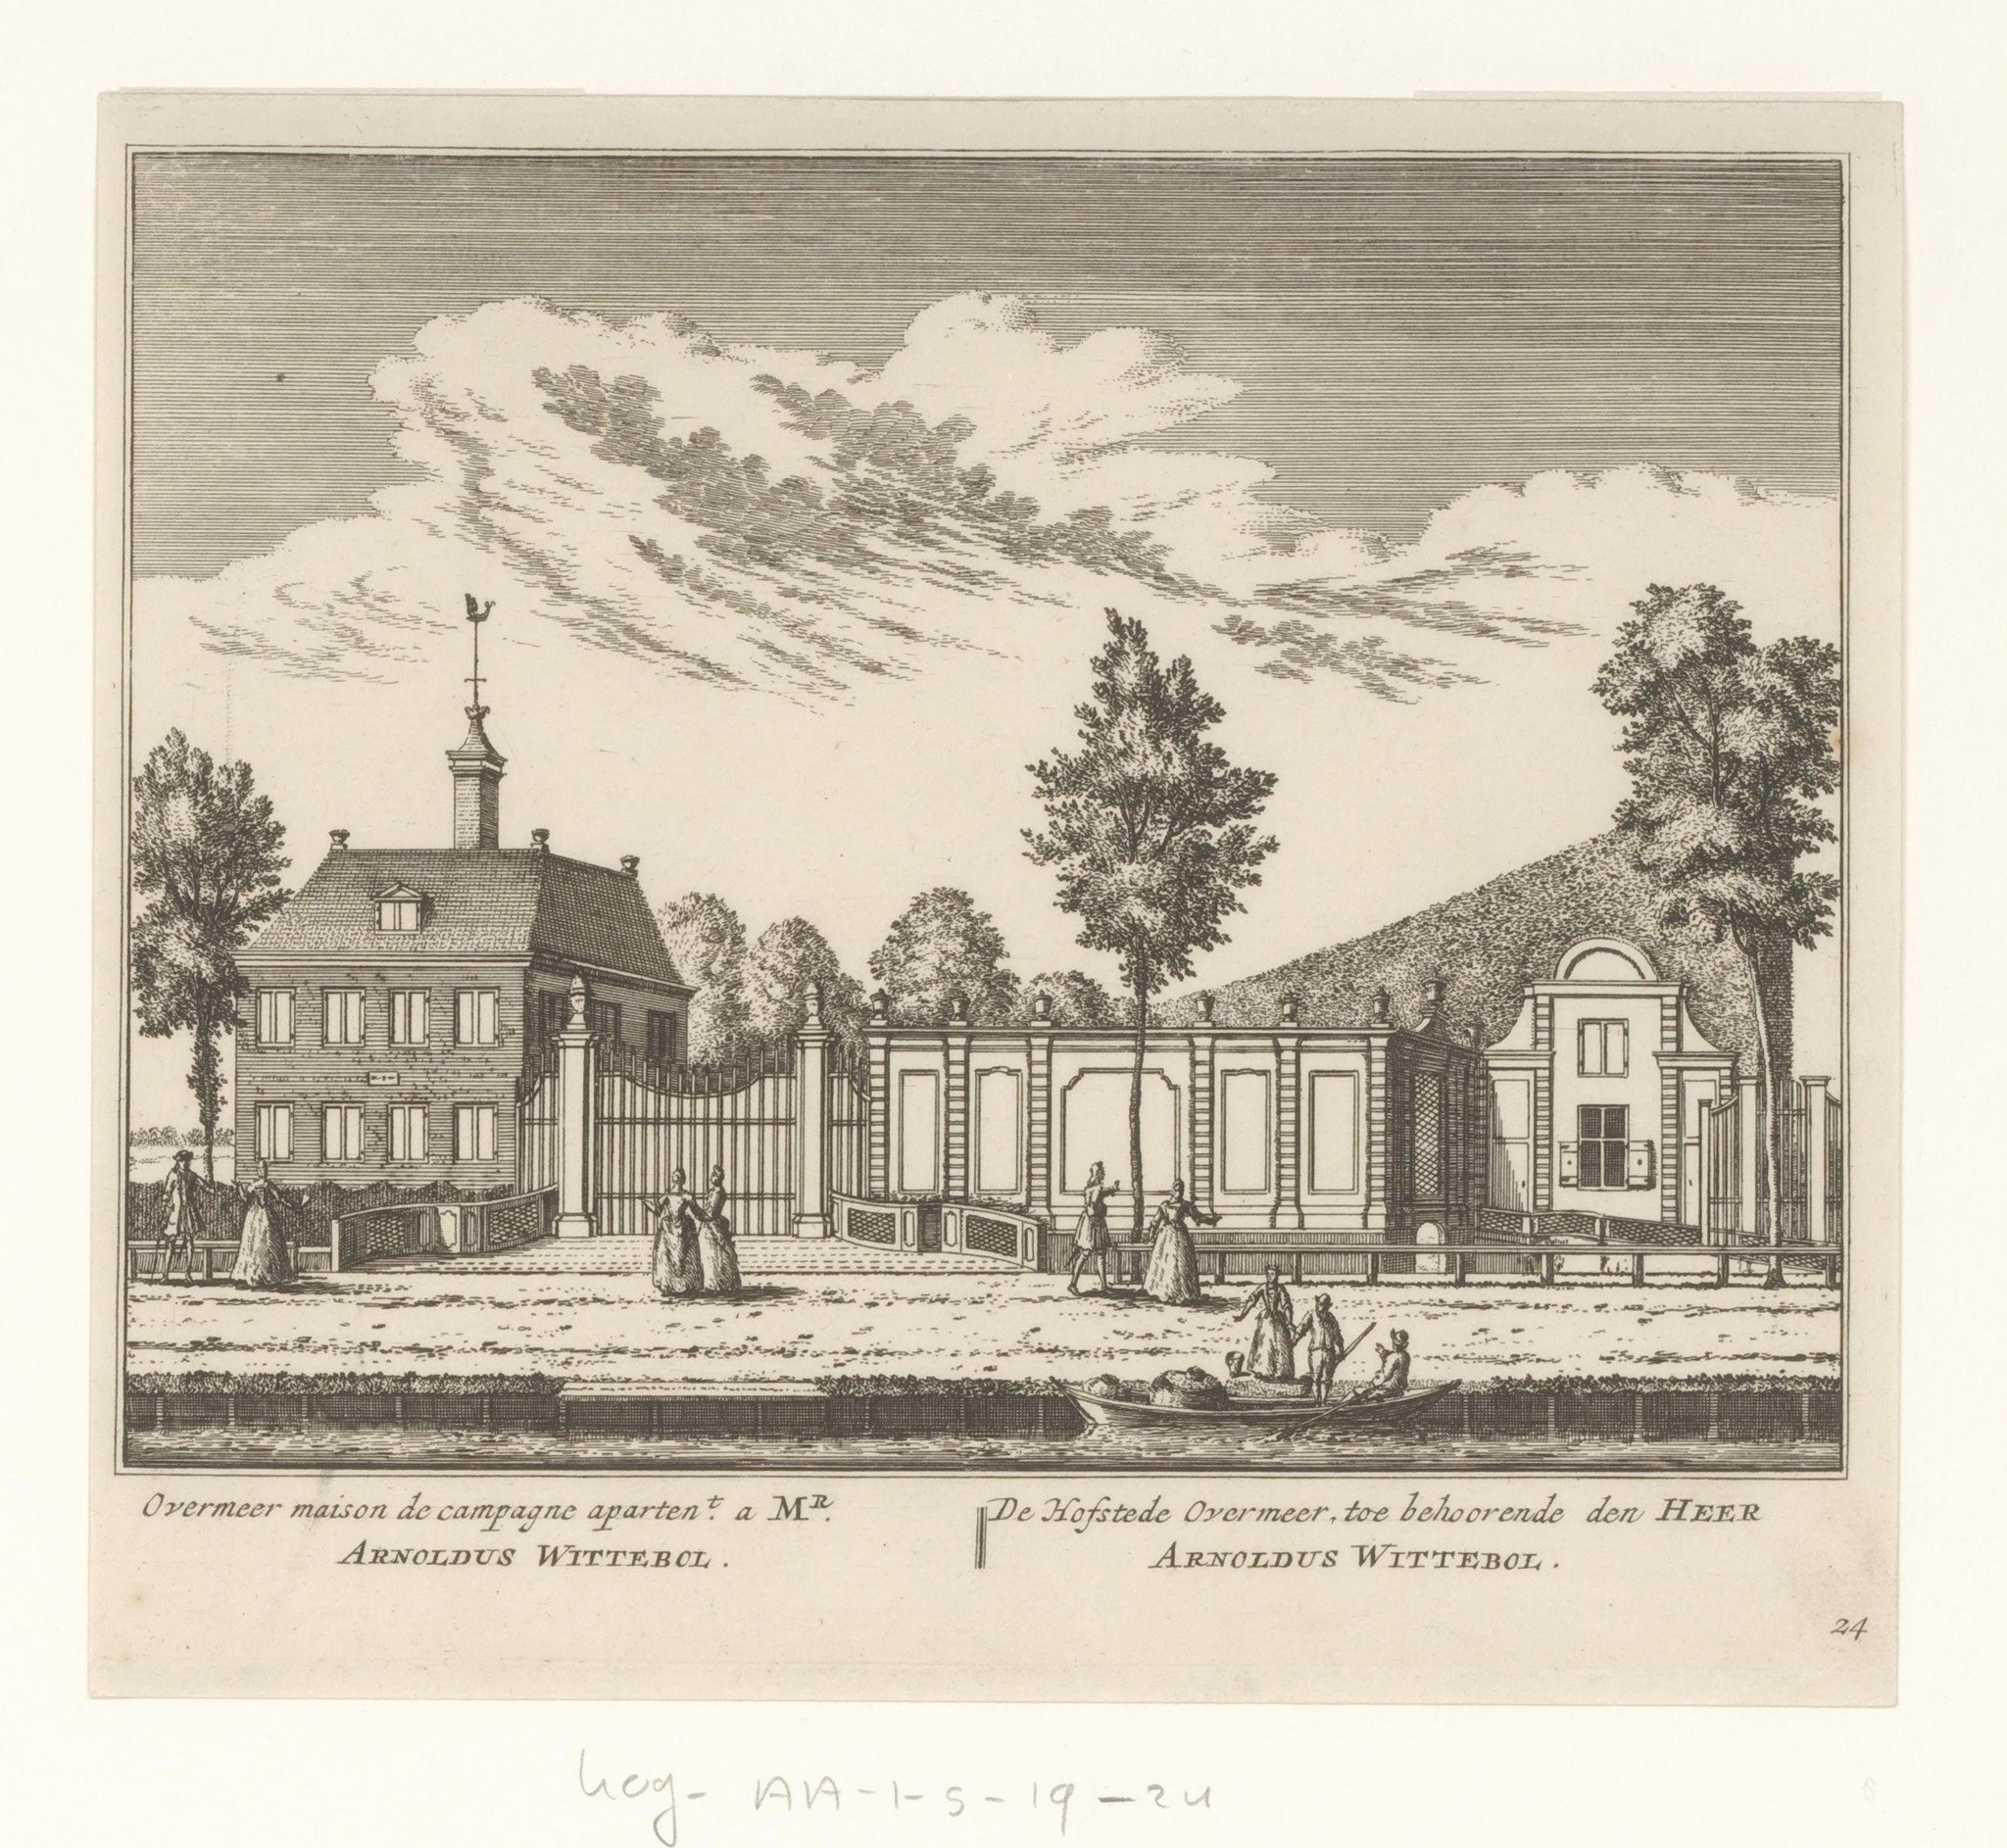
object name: print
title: Gezicht op buitenplaats Overmeer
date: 1730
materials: paper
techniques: etching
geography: amsterdam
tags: city-view in general; 'veduta', river, rural housing, e.g. country-house, villa, cottage, gate, entrance, boat propelled by man or animal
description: Prent waarschijnlijk uit: Tijsens, Gijsbert. Hollands Arcadia, of de vermaarde rivier den Amstel (...) naar 't léven getekend en in 't ligt gebragt door Abraham Rademaker (...). Amsterdam: Leonardus Schenk, 1730.